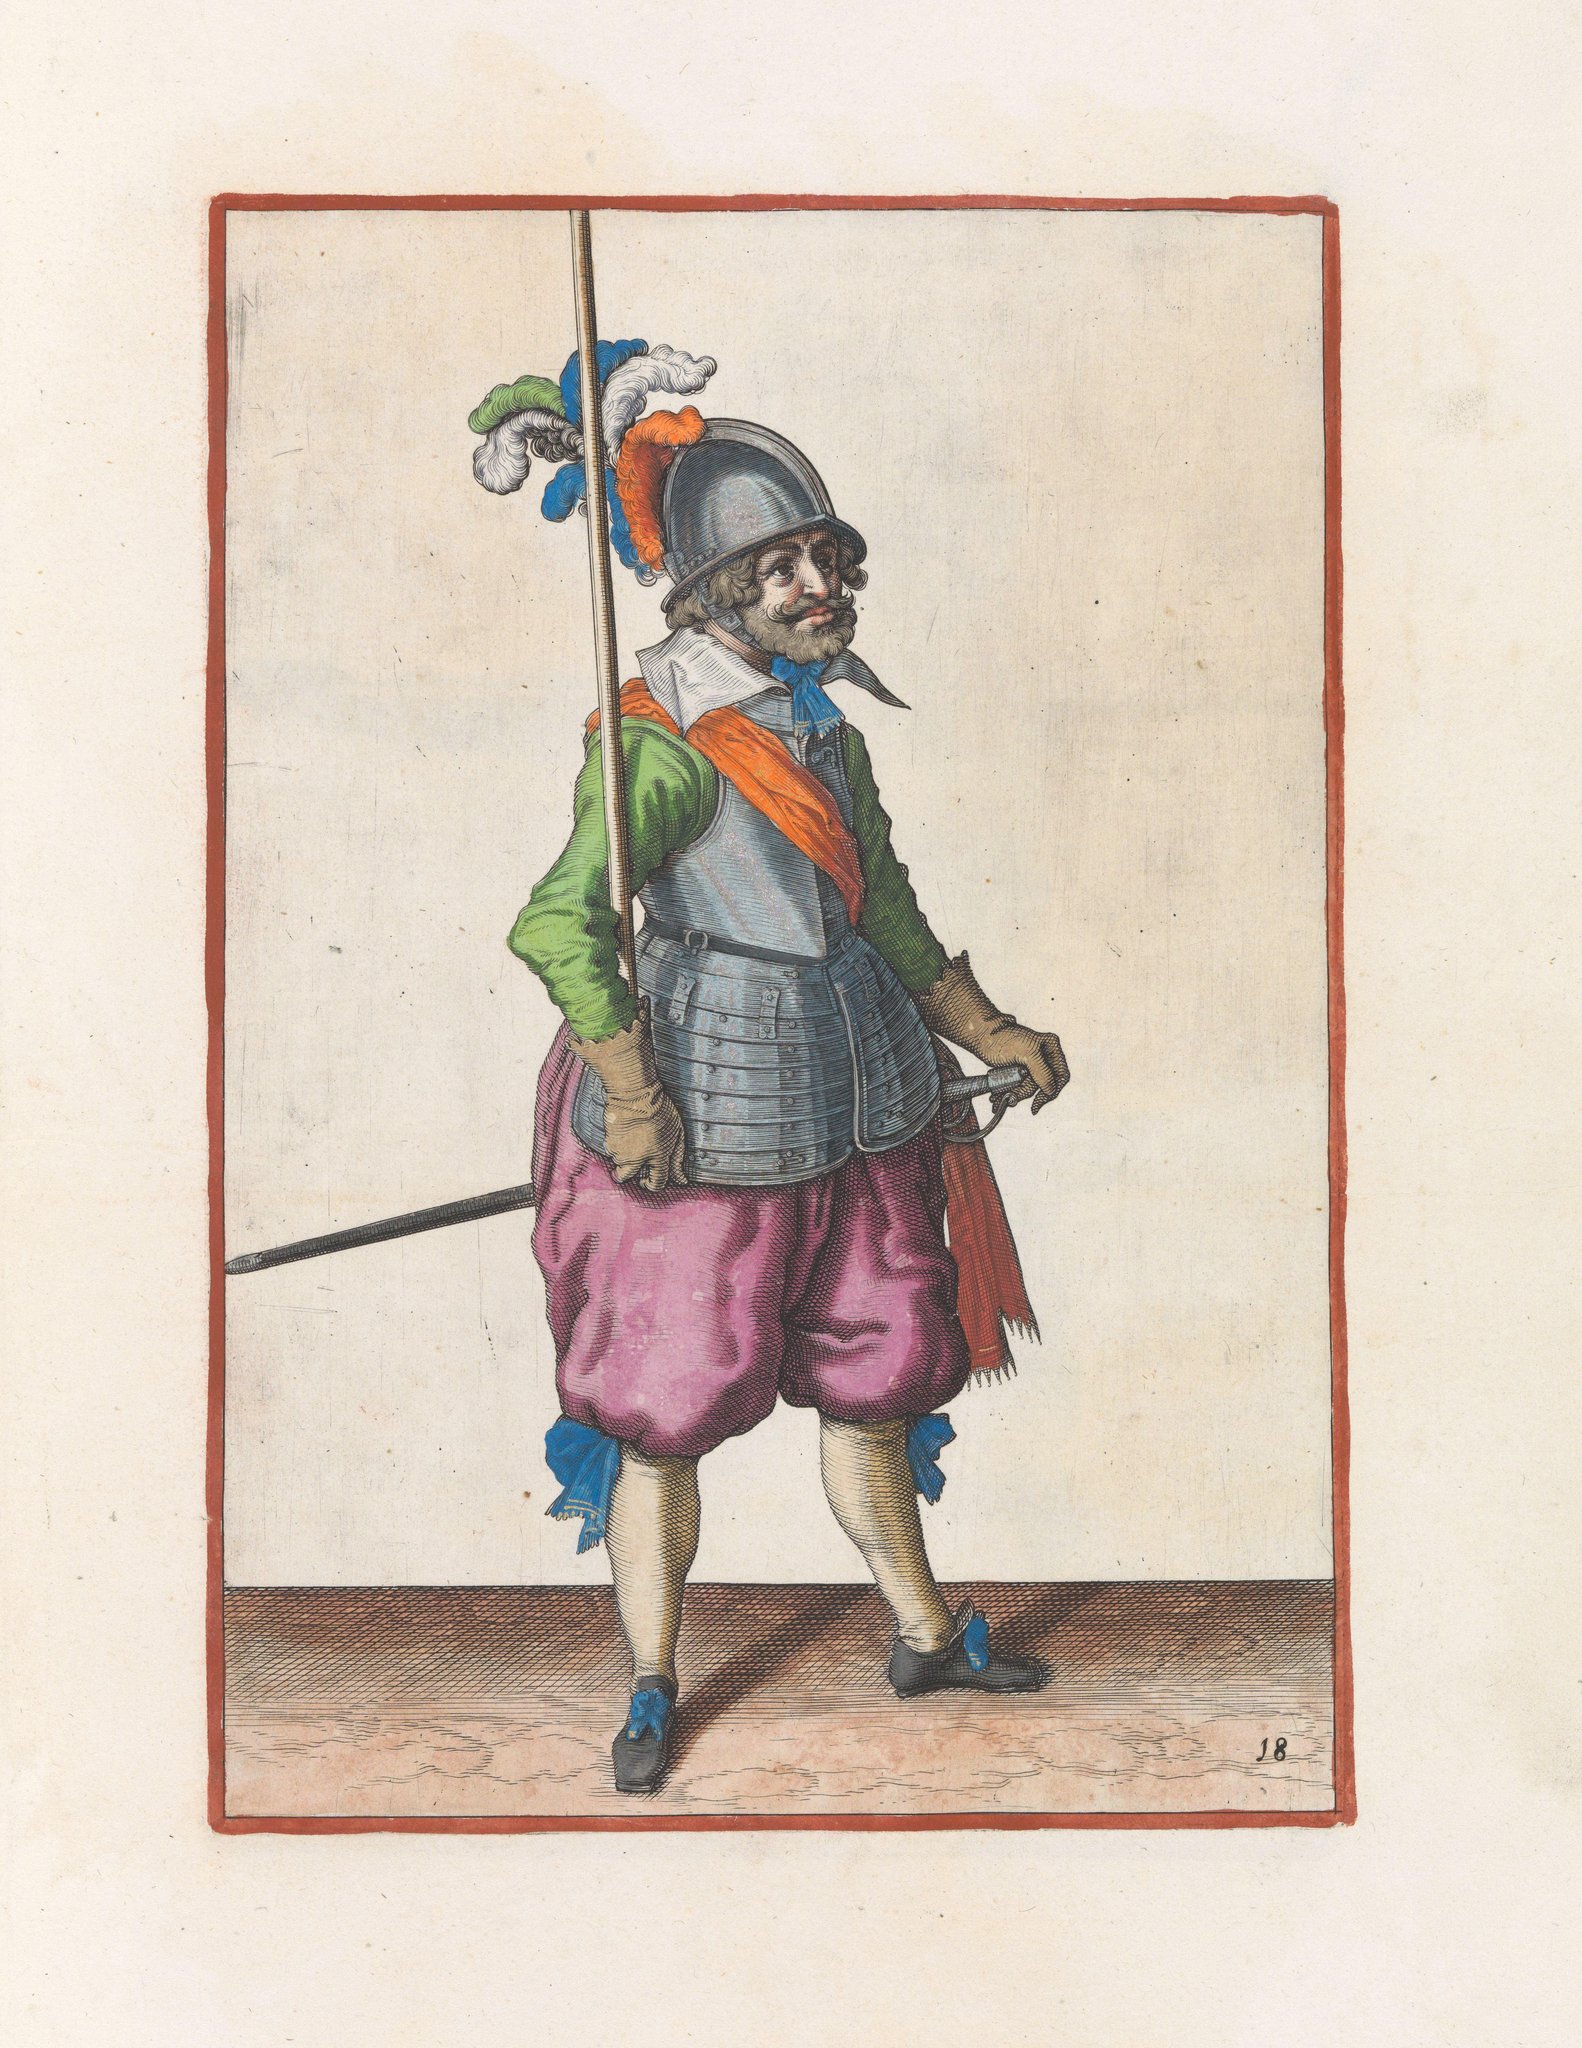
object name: print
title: Soldaat die zijn spies in de rechterhand verticaal draagt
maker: jacques de gheyn (ii)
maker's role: painter, print maker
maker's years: 1565-1629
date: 1597-1607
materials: paper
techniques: engraving, hand coloring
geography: the hague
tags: handling of weapons ~ military training, helved weapons, polearms (for striking, hacking, thrusting): lance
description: Een soldaat, ten voeten uit, die een spies (lans) in zijn rechterhand geleund tegen zijn rechterarm verticaal vasthoudt. Deze prent is onderdeel van de reeks van 32 met de hand genummerde prenten van spiesdragers in de Wapenhandelinghe. Dit exemplaar met het nummer gedrukt.